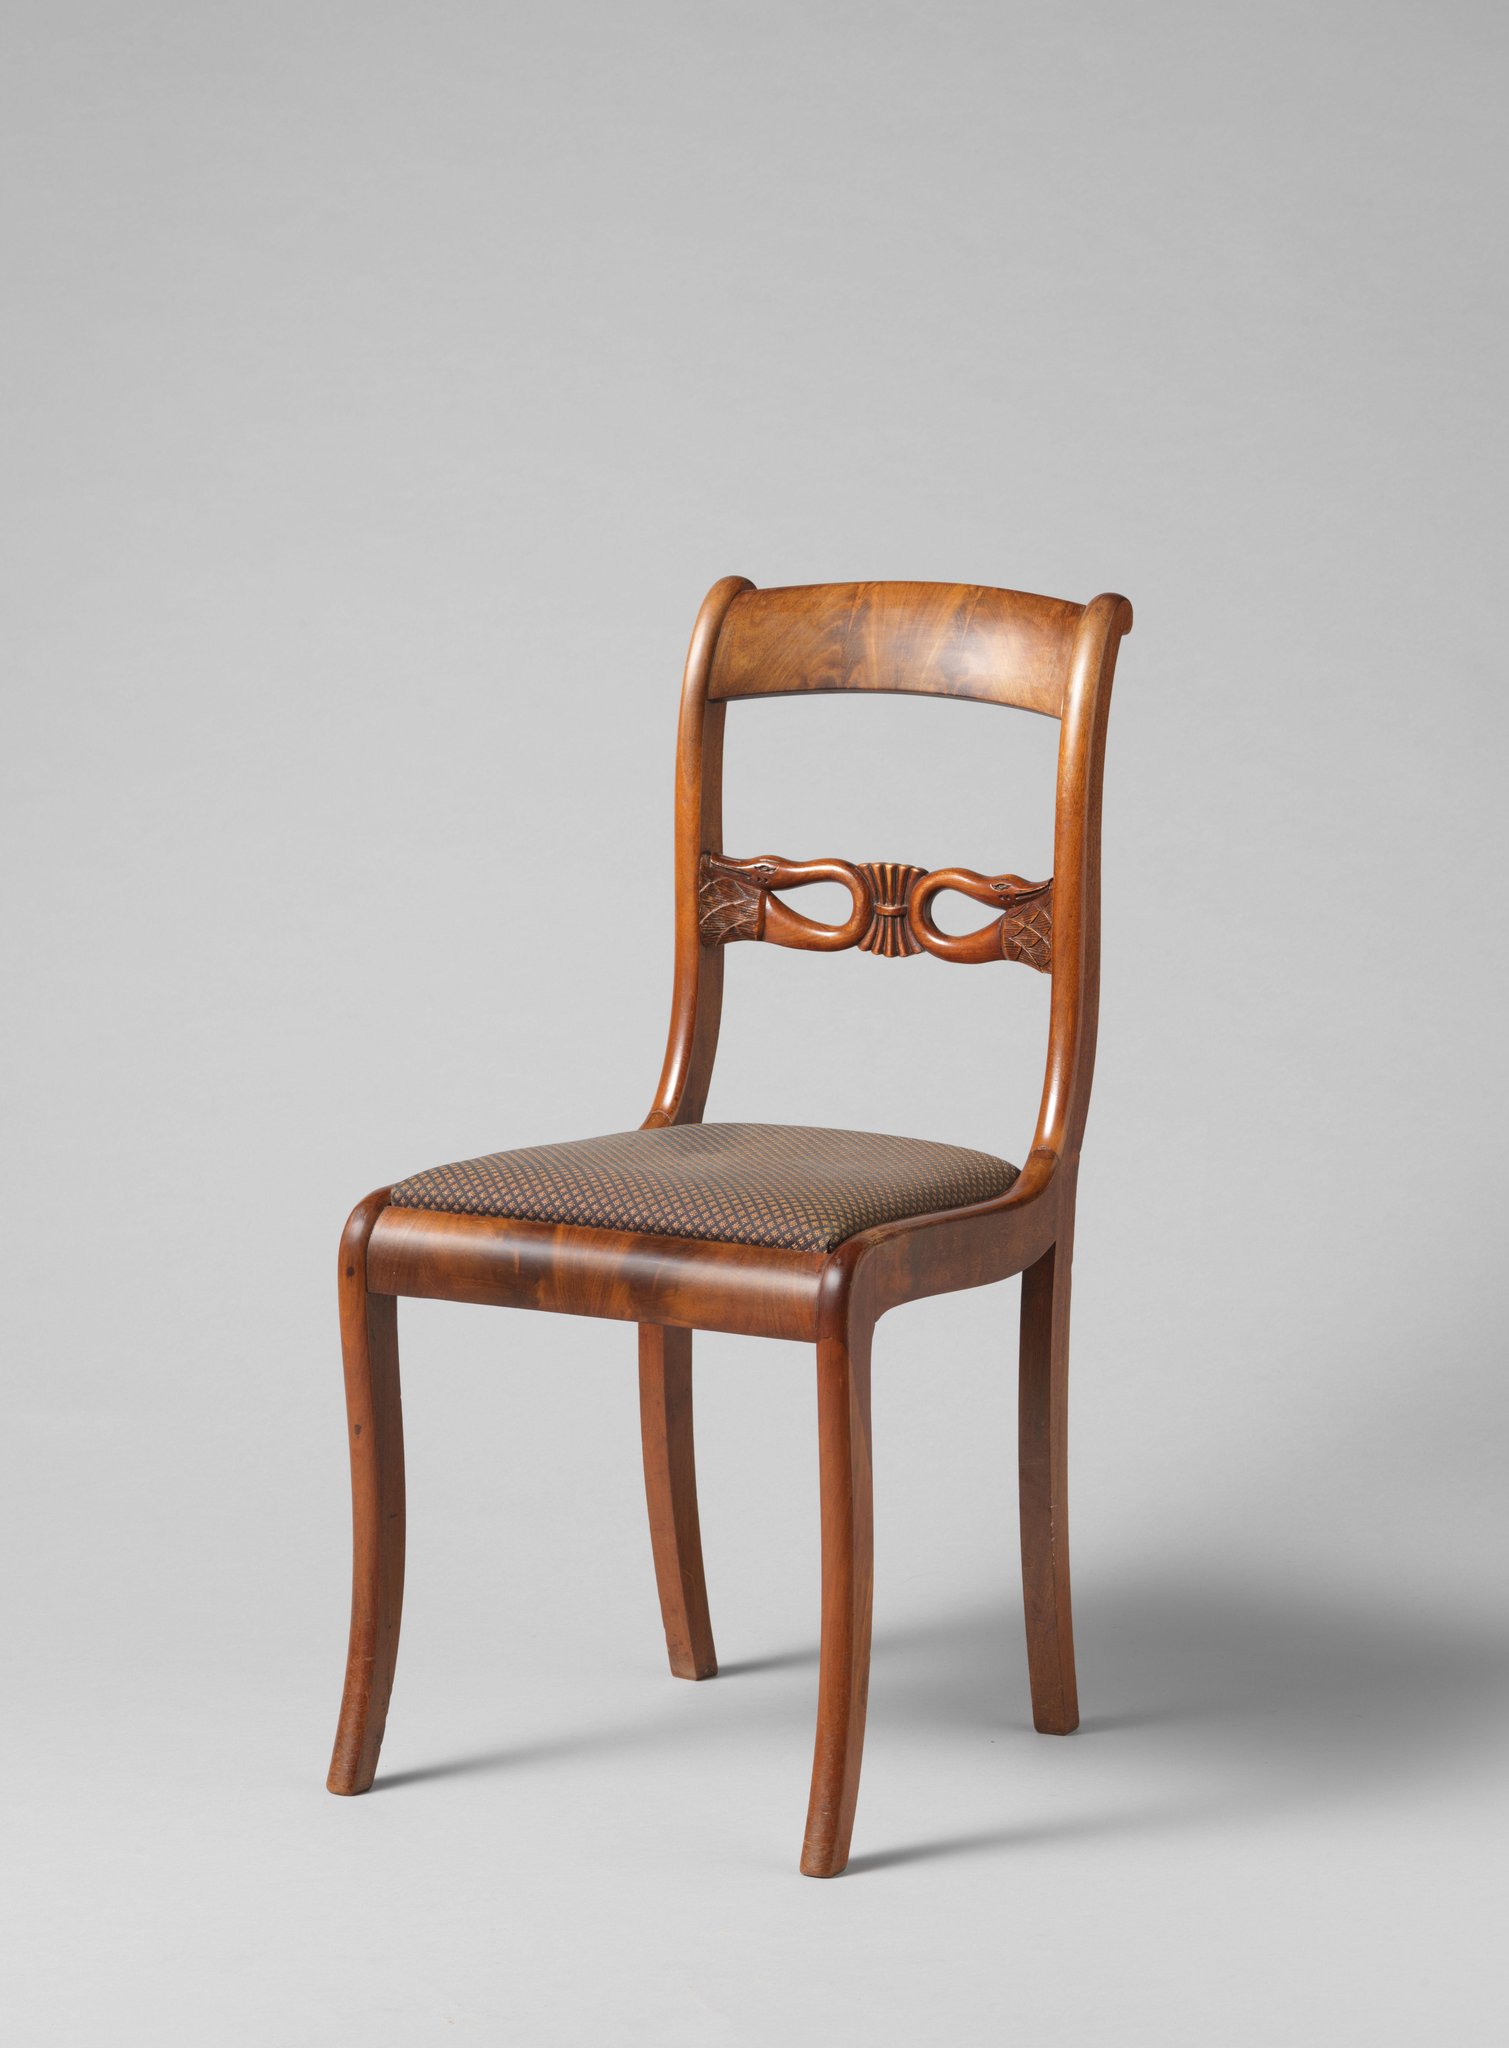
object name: furniture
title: Stoel met zwanen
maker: Anonymous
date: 1830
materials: wood, textile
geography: netherlands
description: Stoel uit een set van tien stoelen en vier armstoelen van deels massief en deels belijmd mahoniehout op iepenhouten kern. Losse beklede zittingen. De vierkante achterpoten wijken achterwaarts. Negen stoelen en een armstoel hebben vierkante, aan de voorzijde iets afgeronde, voorpoten; de rest heeft ronde gelede voorpoten. De gestrekt S-vormige ruggen hebben een gebeeldhouwde tussenregel met een palmet geflankeerd door twee toegewende, met de halzen terugbuigende zwanen. De platte voluutvormige armleggers lopen hoog in de rug over.